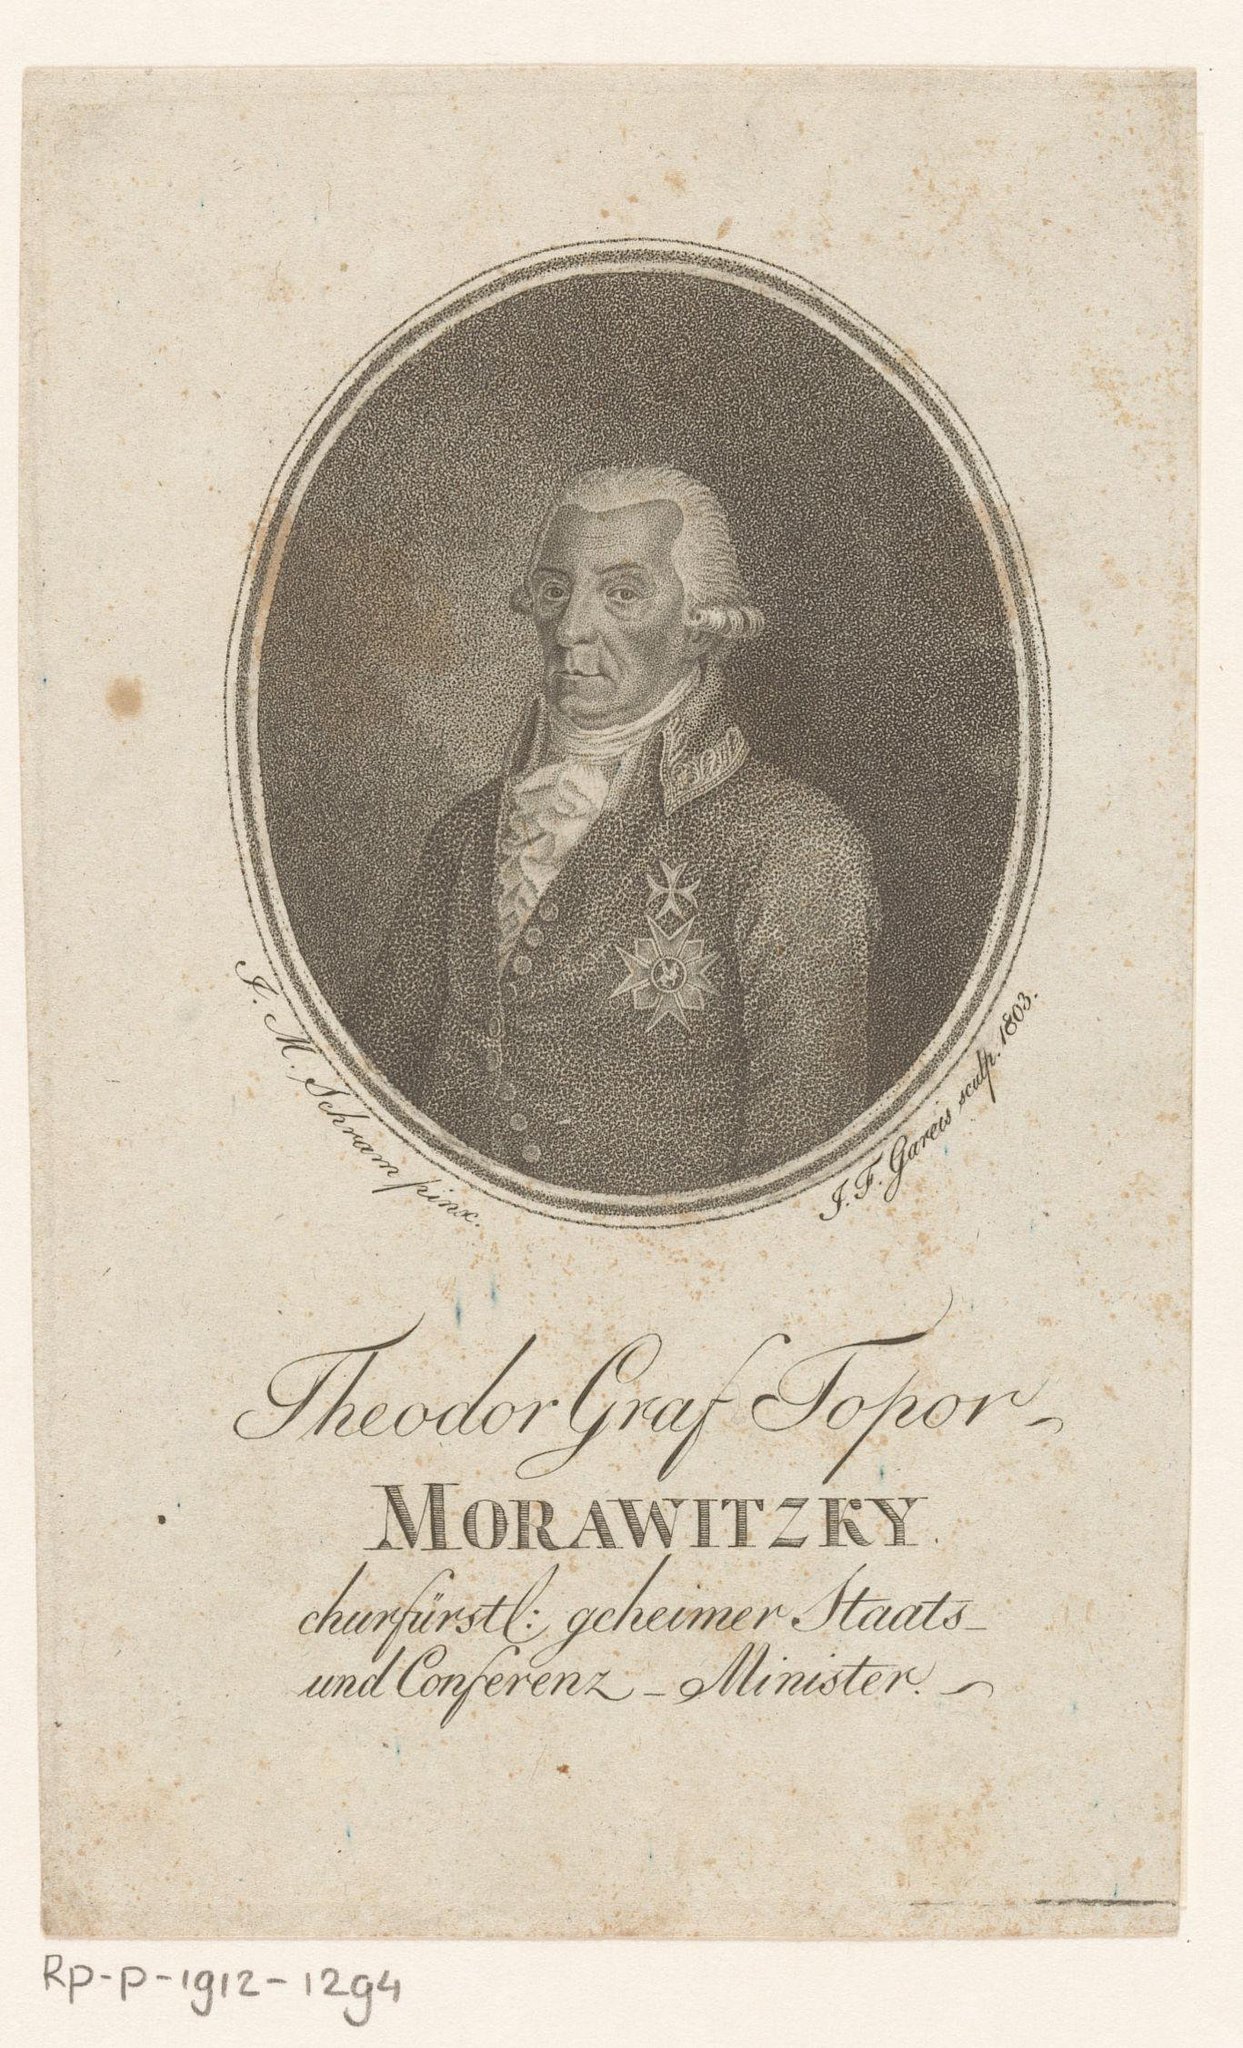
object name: print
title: Portret van Theodor Heinrich Topor von Morawitzky zu Rudnitz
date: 1803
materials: paper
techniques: stippling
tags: knighthood order, historical persons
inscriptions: collector's mark: Lugt 2228